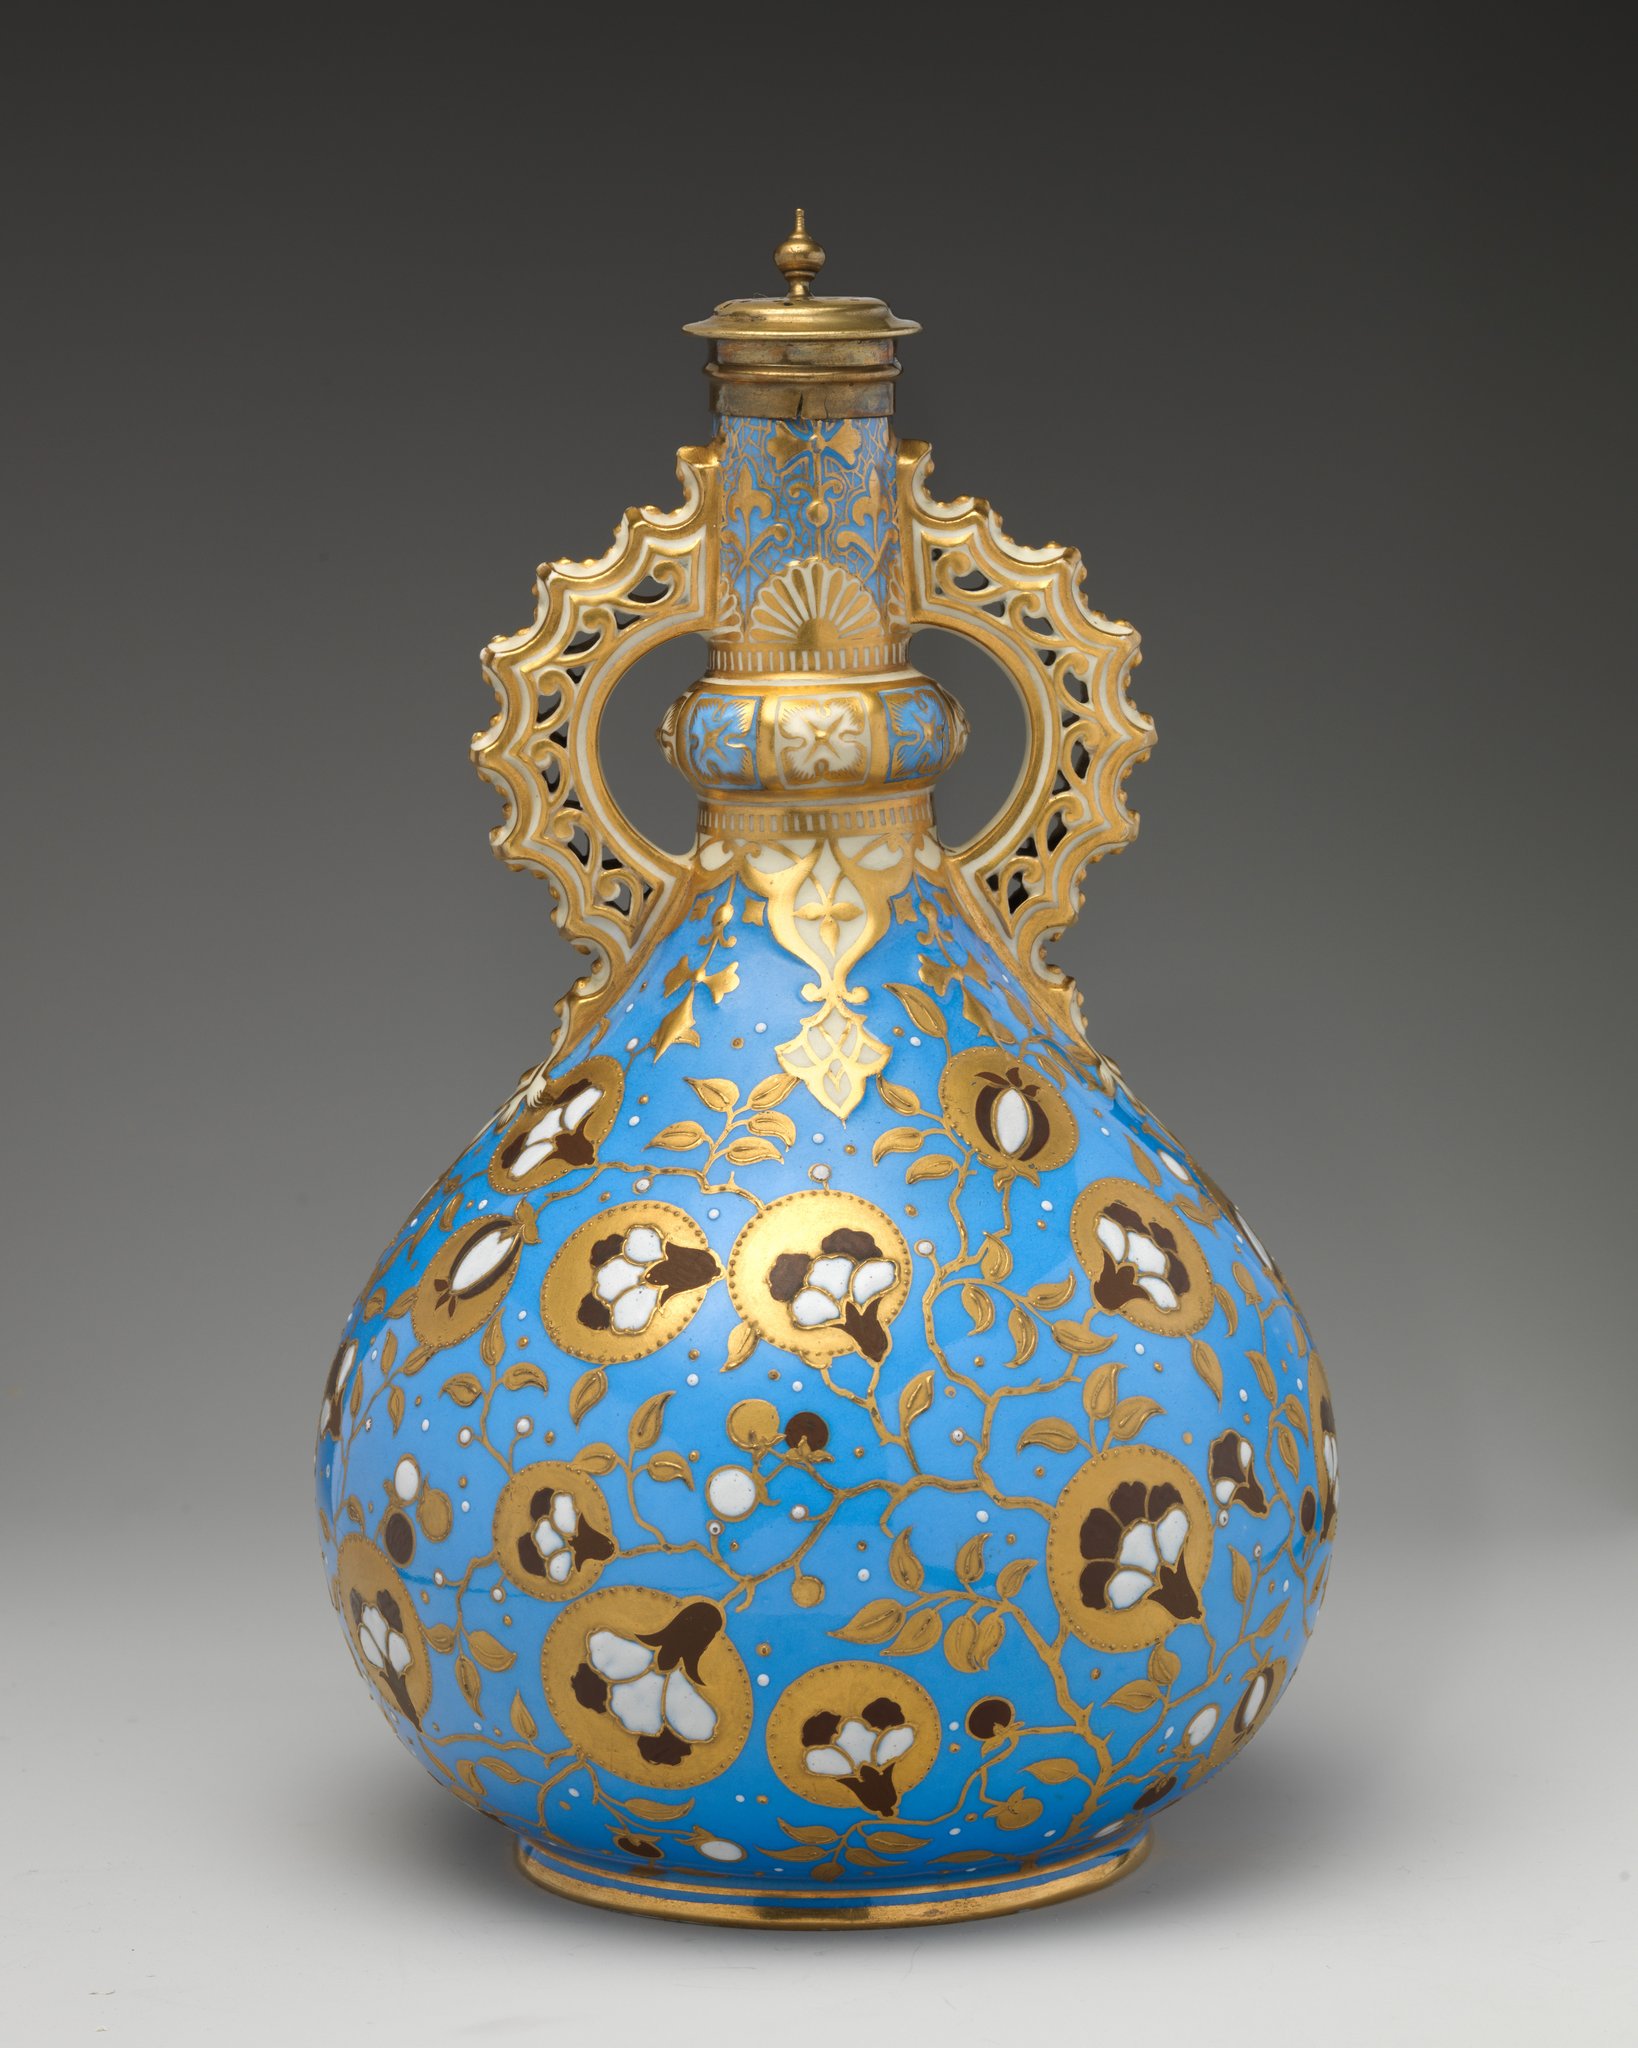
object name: bottle with stopper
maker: crown derby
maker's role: maker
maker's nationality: british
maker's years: 1750-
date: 1885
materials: porcelain